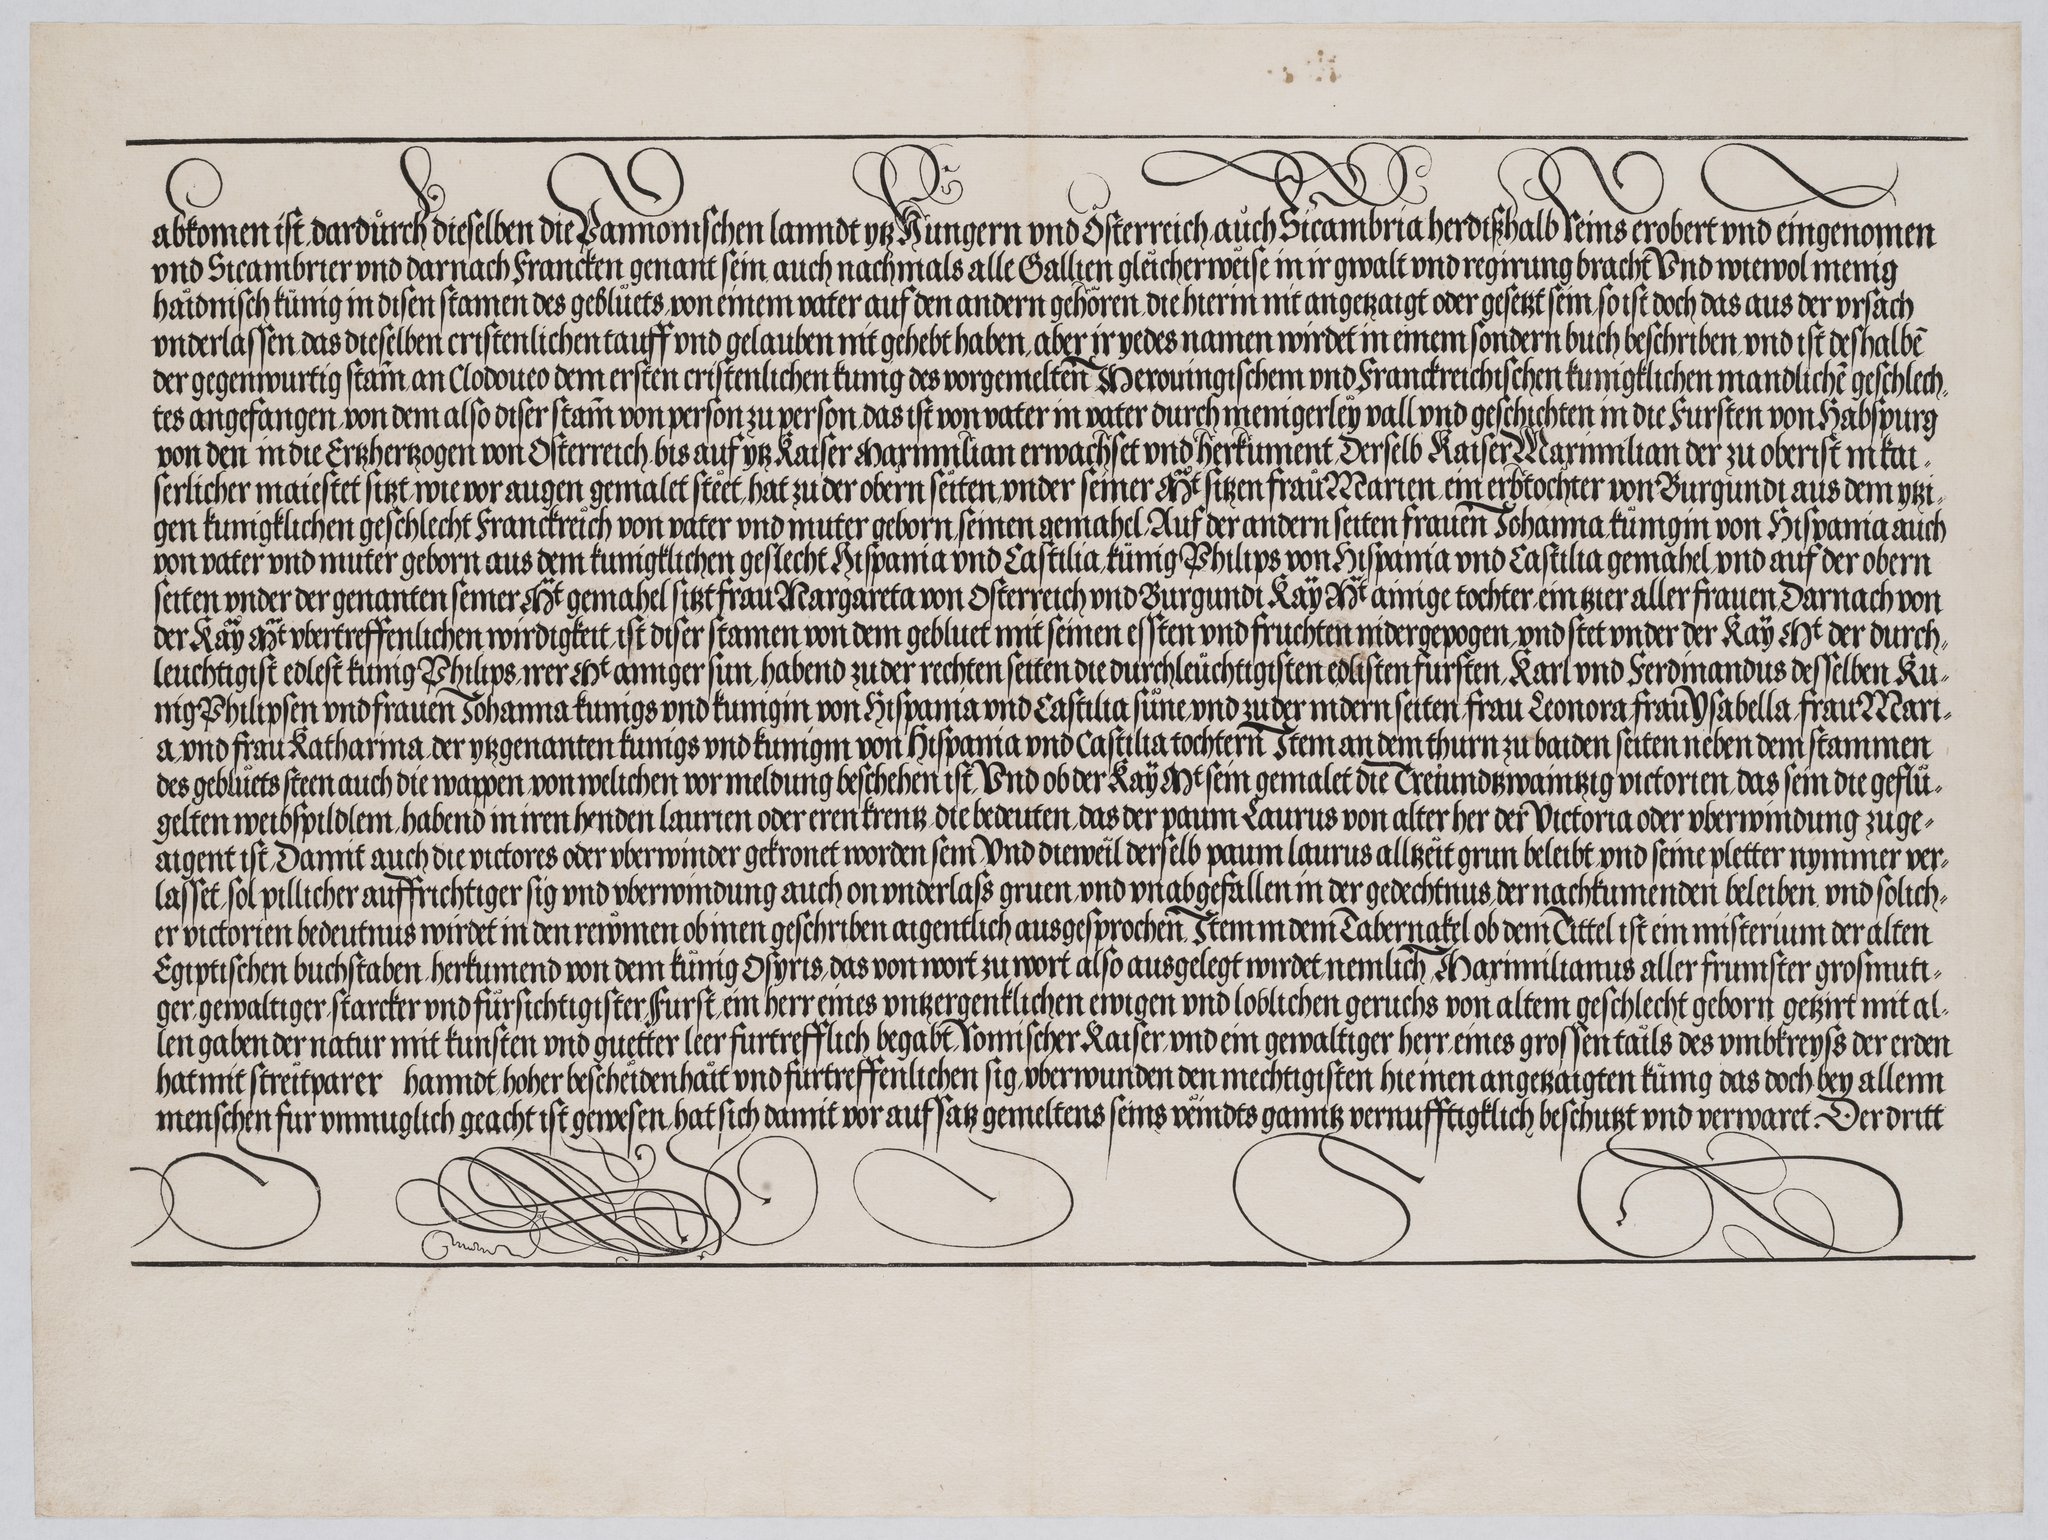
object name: print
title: Explanatory Text, Part II, from the Arch of Honor, proof, dated 1515, printed 1517-18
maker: hieronymus andreae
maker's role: block cutter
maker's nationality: german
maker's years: 1525-1556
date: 1515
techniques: letterpress, woodcut